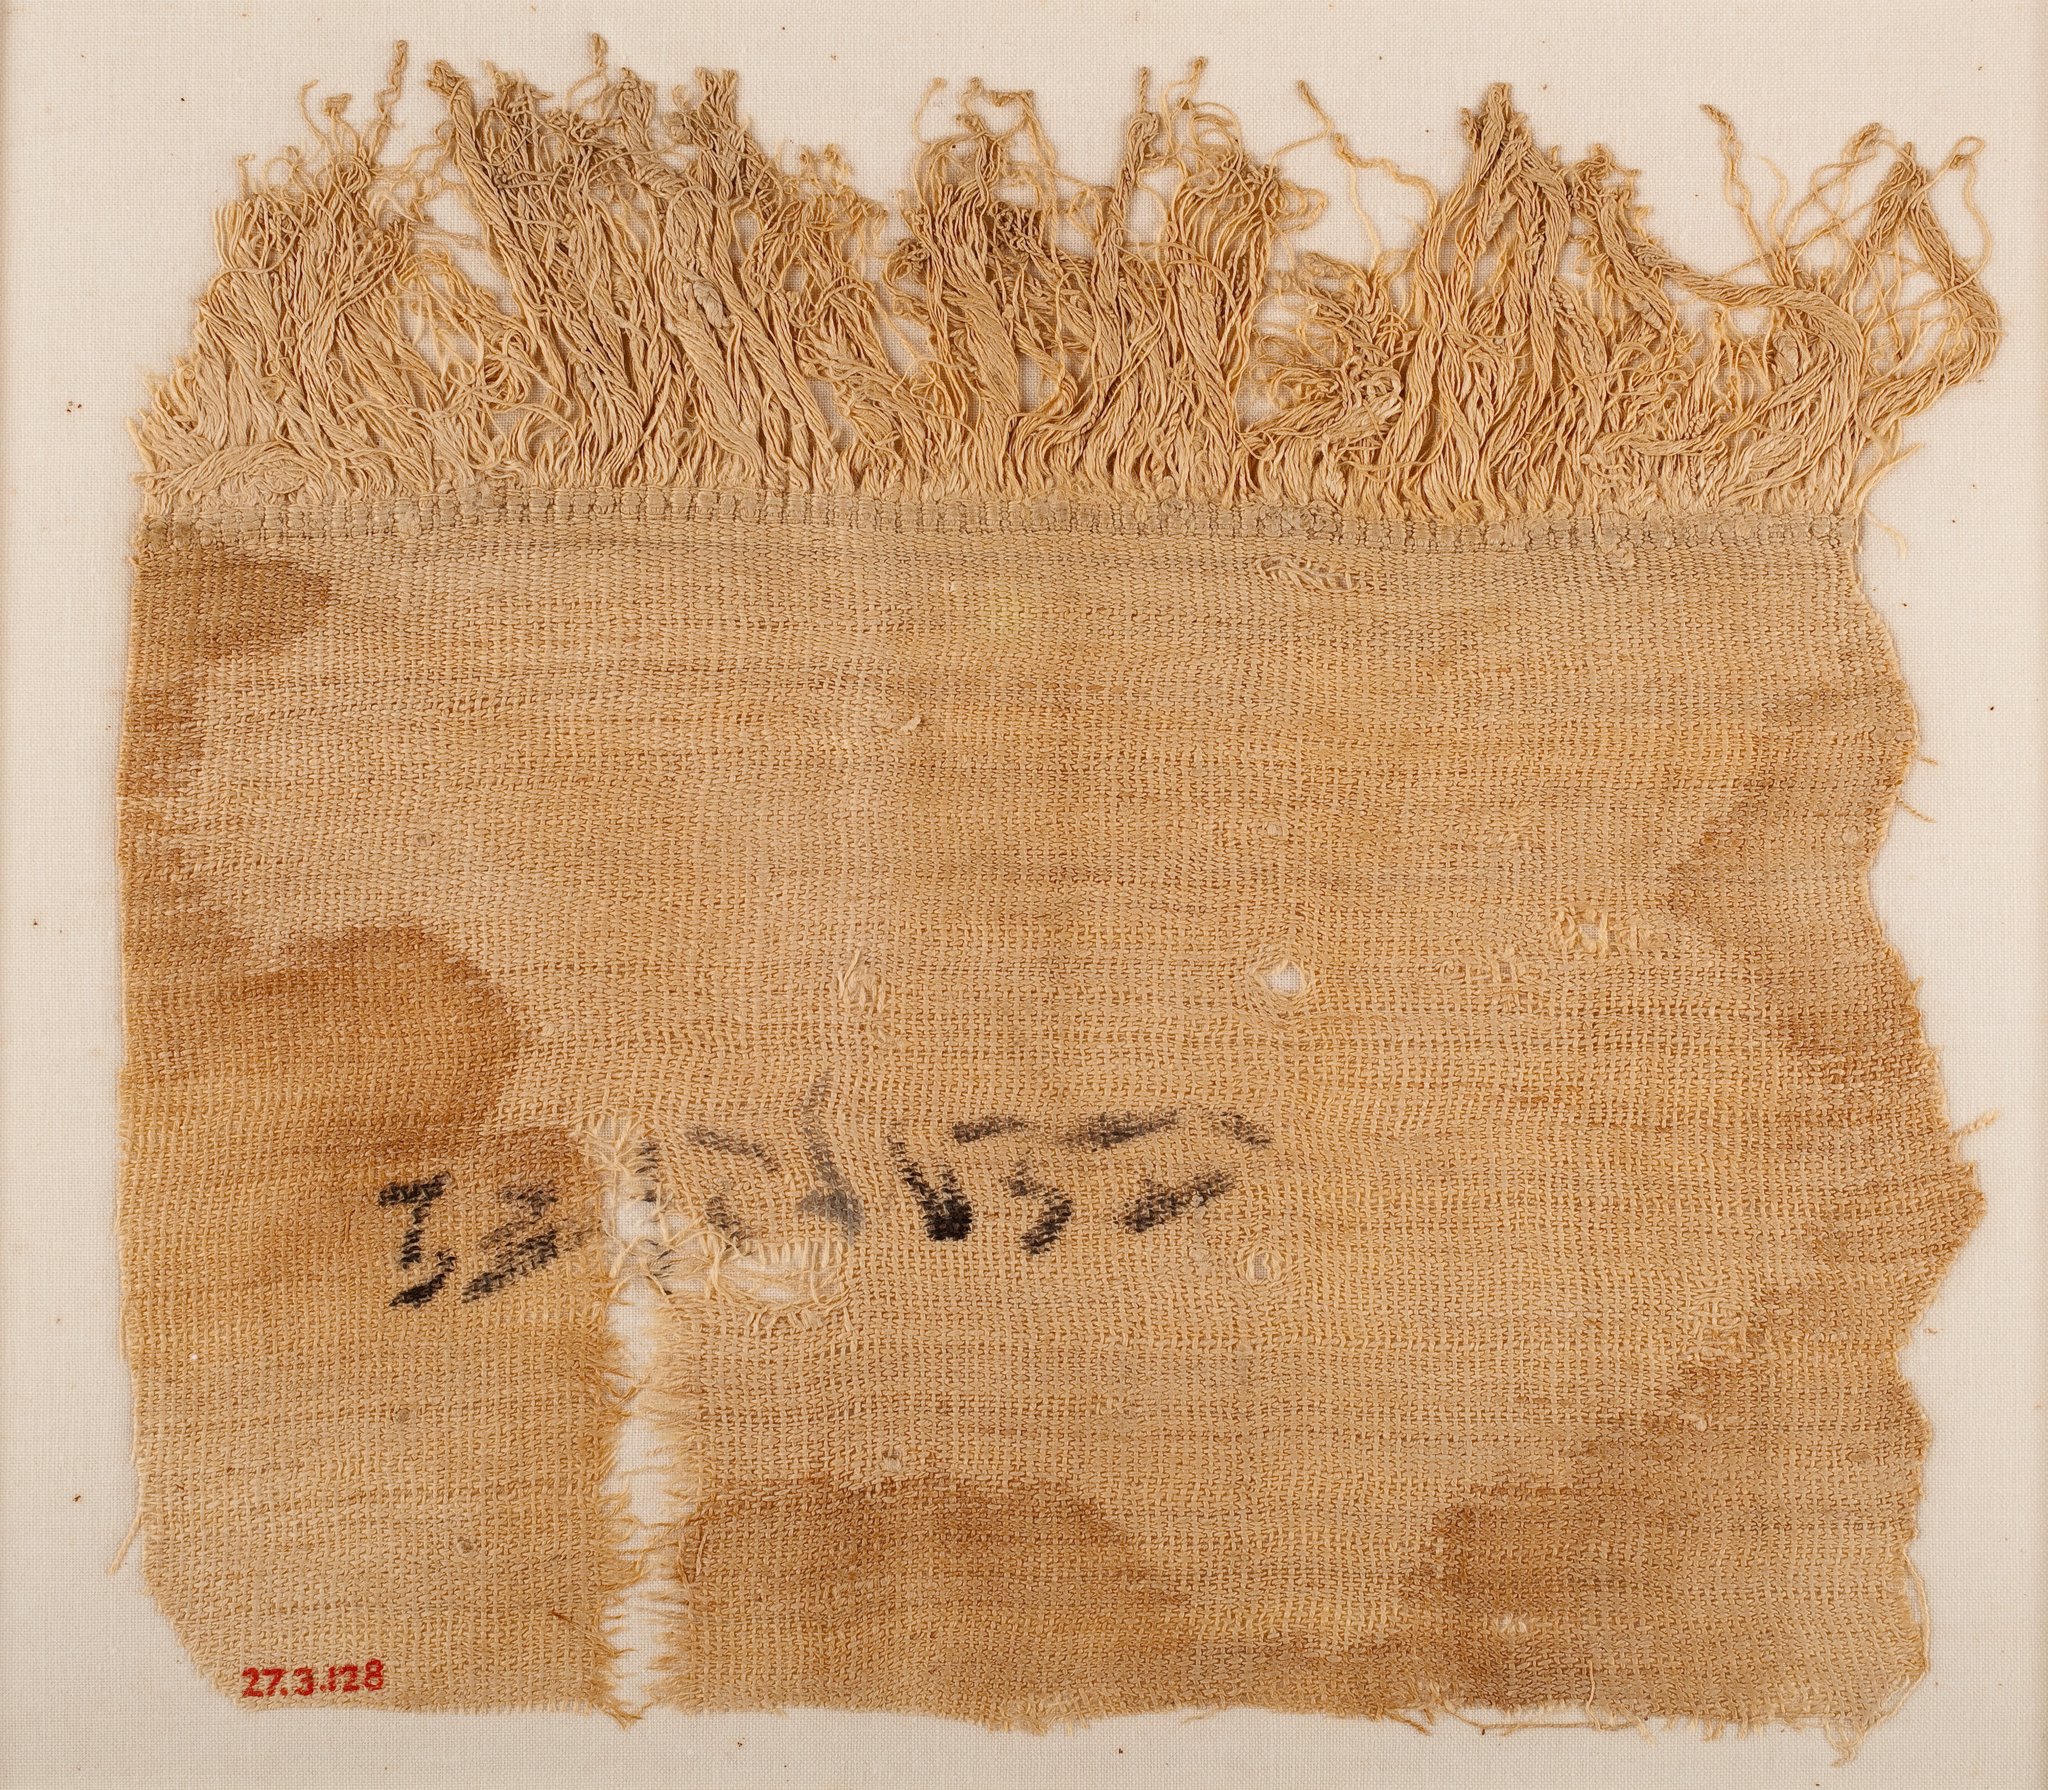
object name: linen mark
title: Linen mark (Type XXX)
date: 1961-1917 BCE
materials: linen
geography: egypt